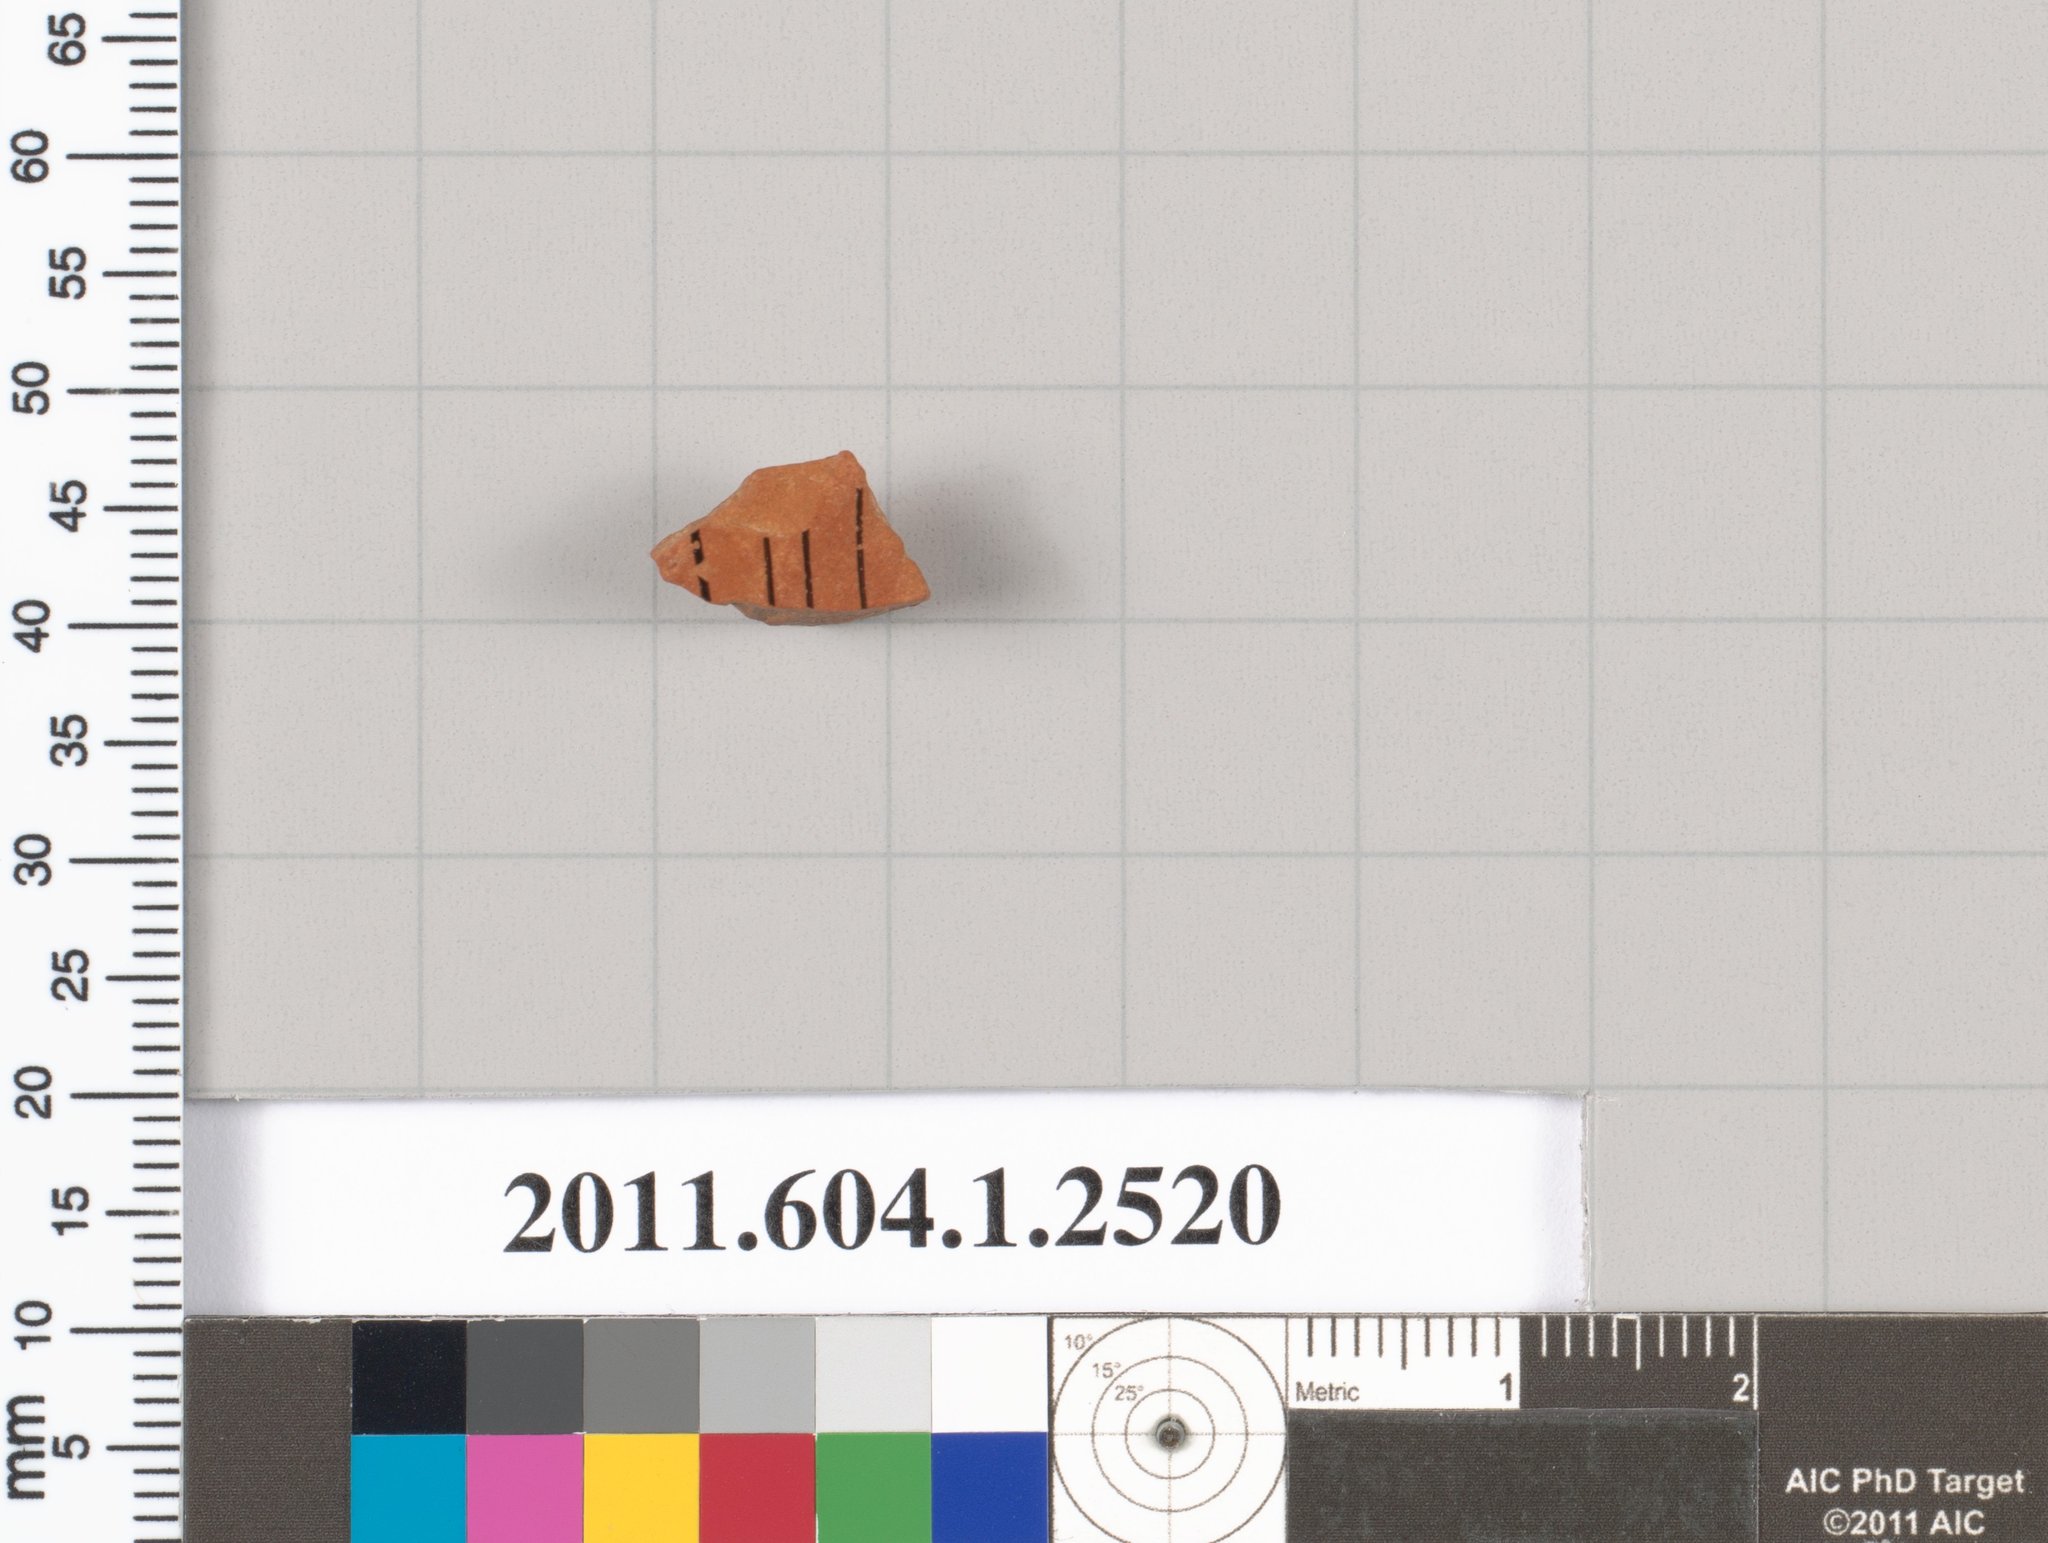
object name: kylix fragment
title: Terracotta fragment of a kylix (drinking cup)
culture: greek, attic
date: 475-451 BCE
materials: terracotta